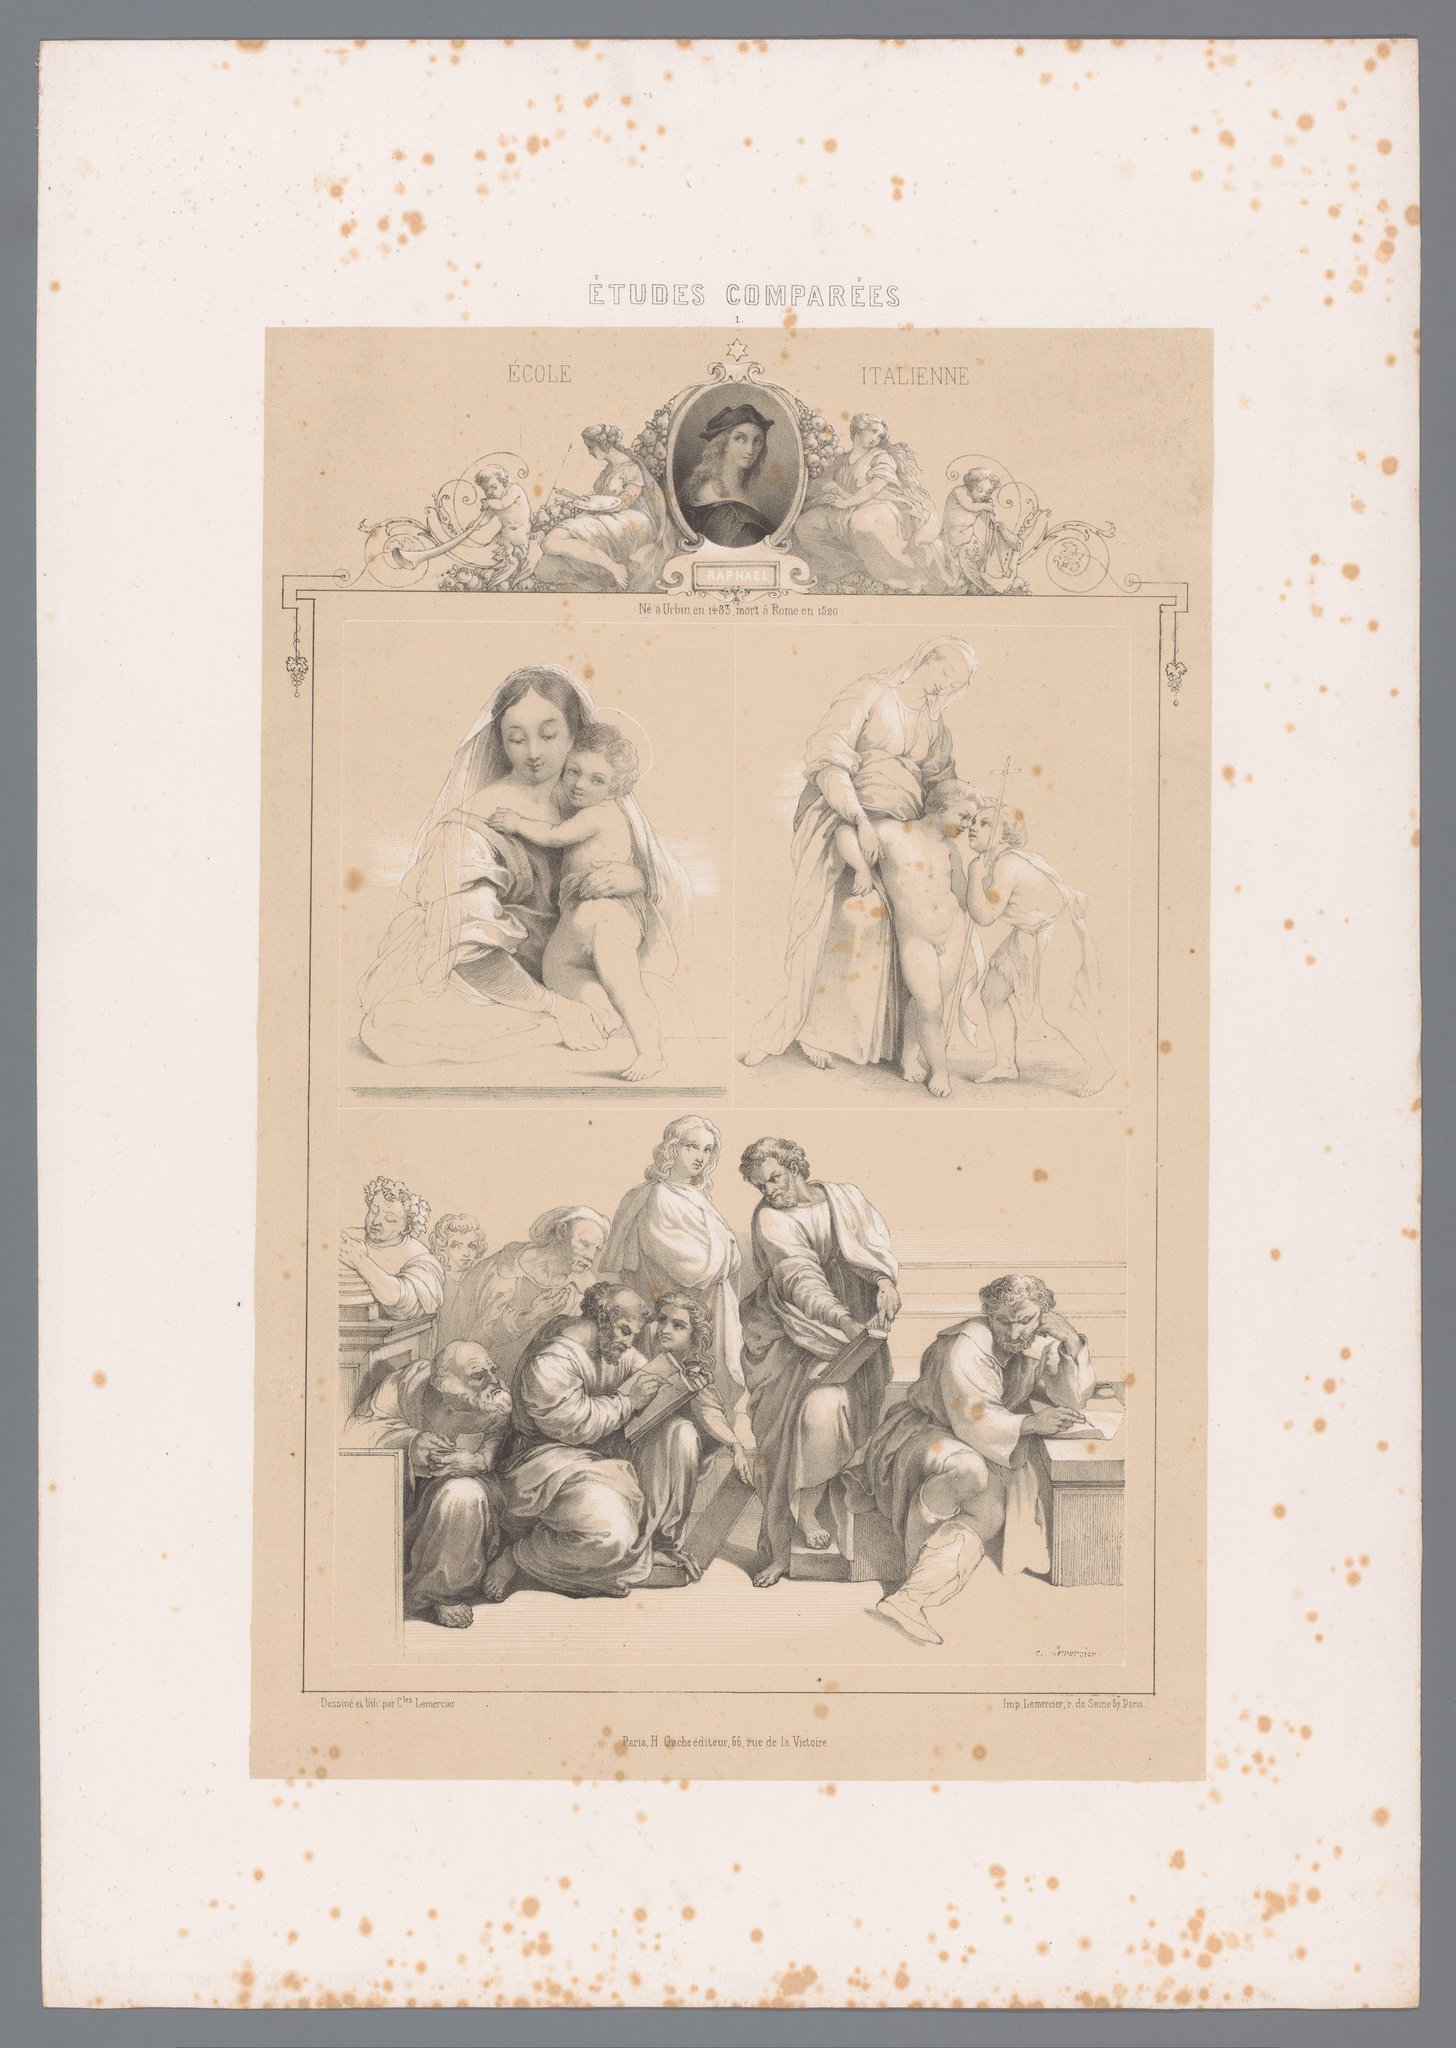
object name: print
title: Études comparées des maitres des diverses écoles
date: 1850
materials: paper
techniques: tone lithography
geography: paris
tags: rome, painter, rafaël, historical persons, painting (including book-illumination, miniature-painting)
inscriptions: collector's mark: Lugt 2228a